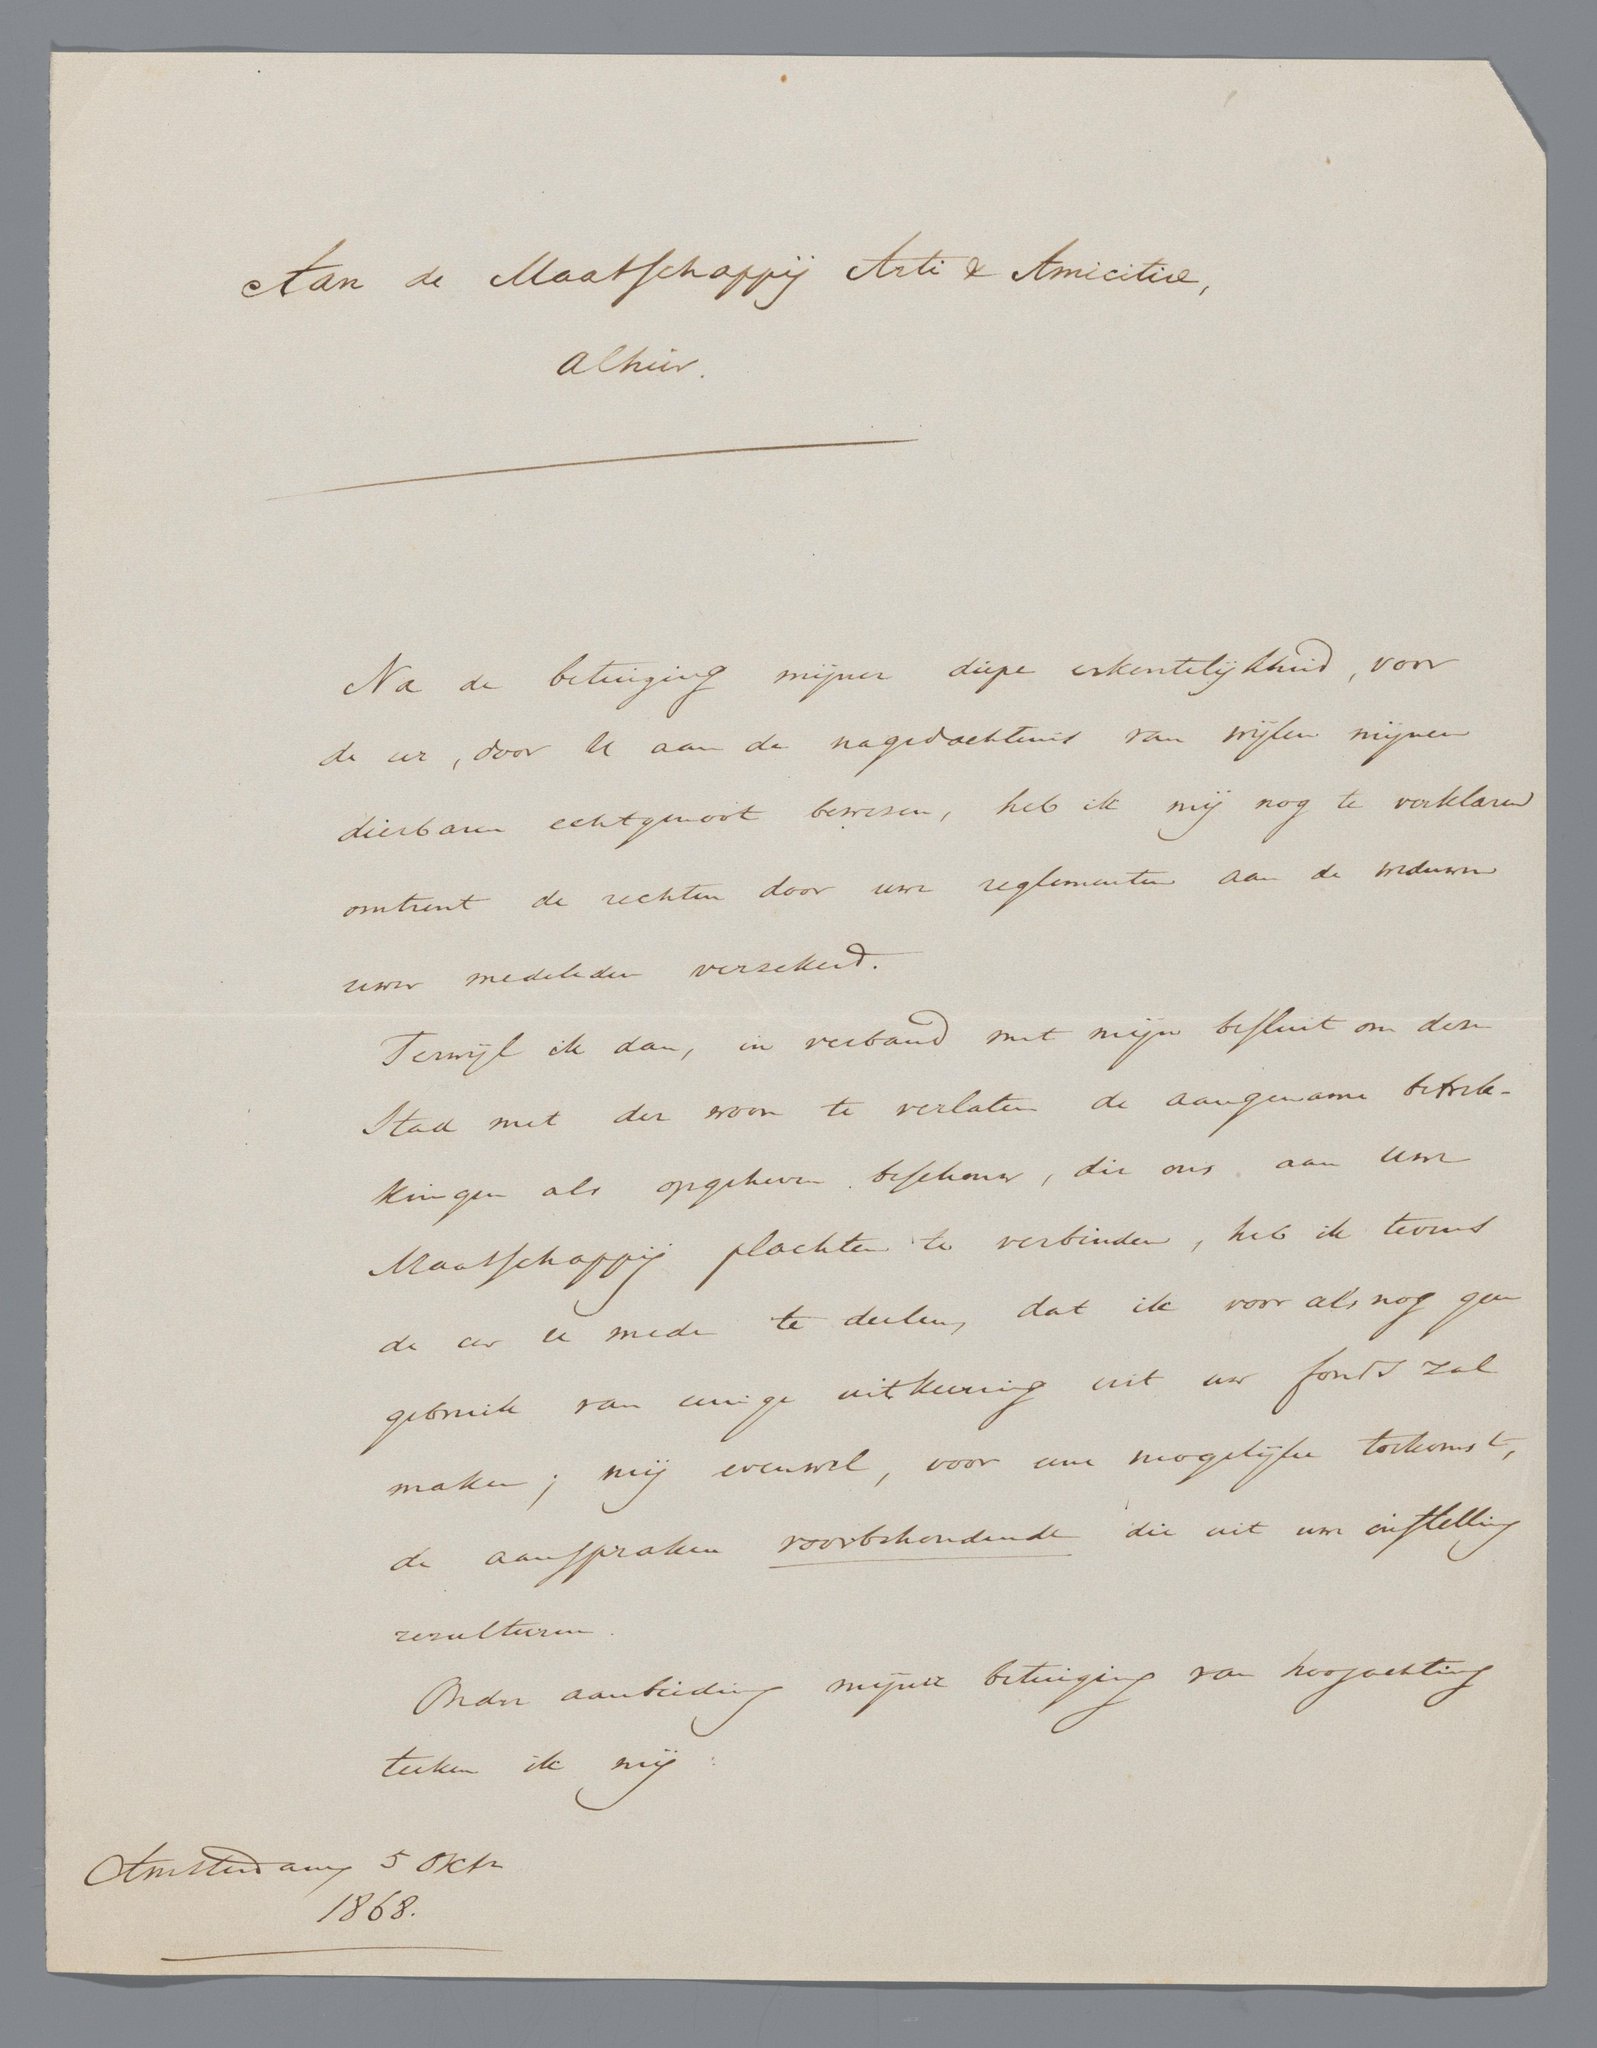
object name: letter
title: Brief aan de Maatschappij Arti et Amicitiae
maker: carolina frederica royer-kerst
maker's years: 1802-1883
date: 1868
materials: ink, paper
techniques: writing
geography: amsterdam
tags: mechelen, amsterdam, draughtsman, sculptor, louis royer, carolina frederica royer-kerst, burial rites